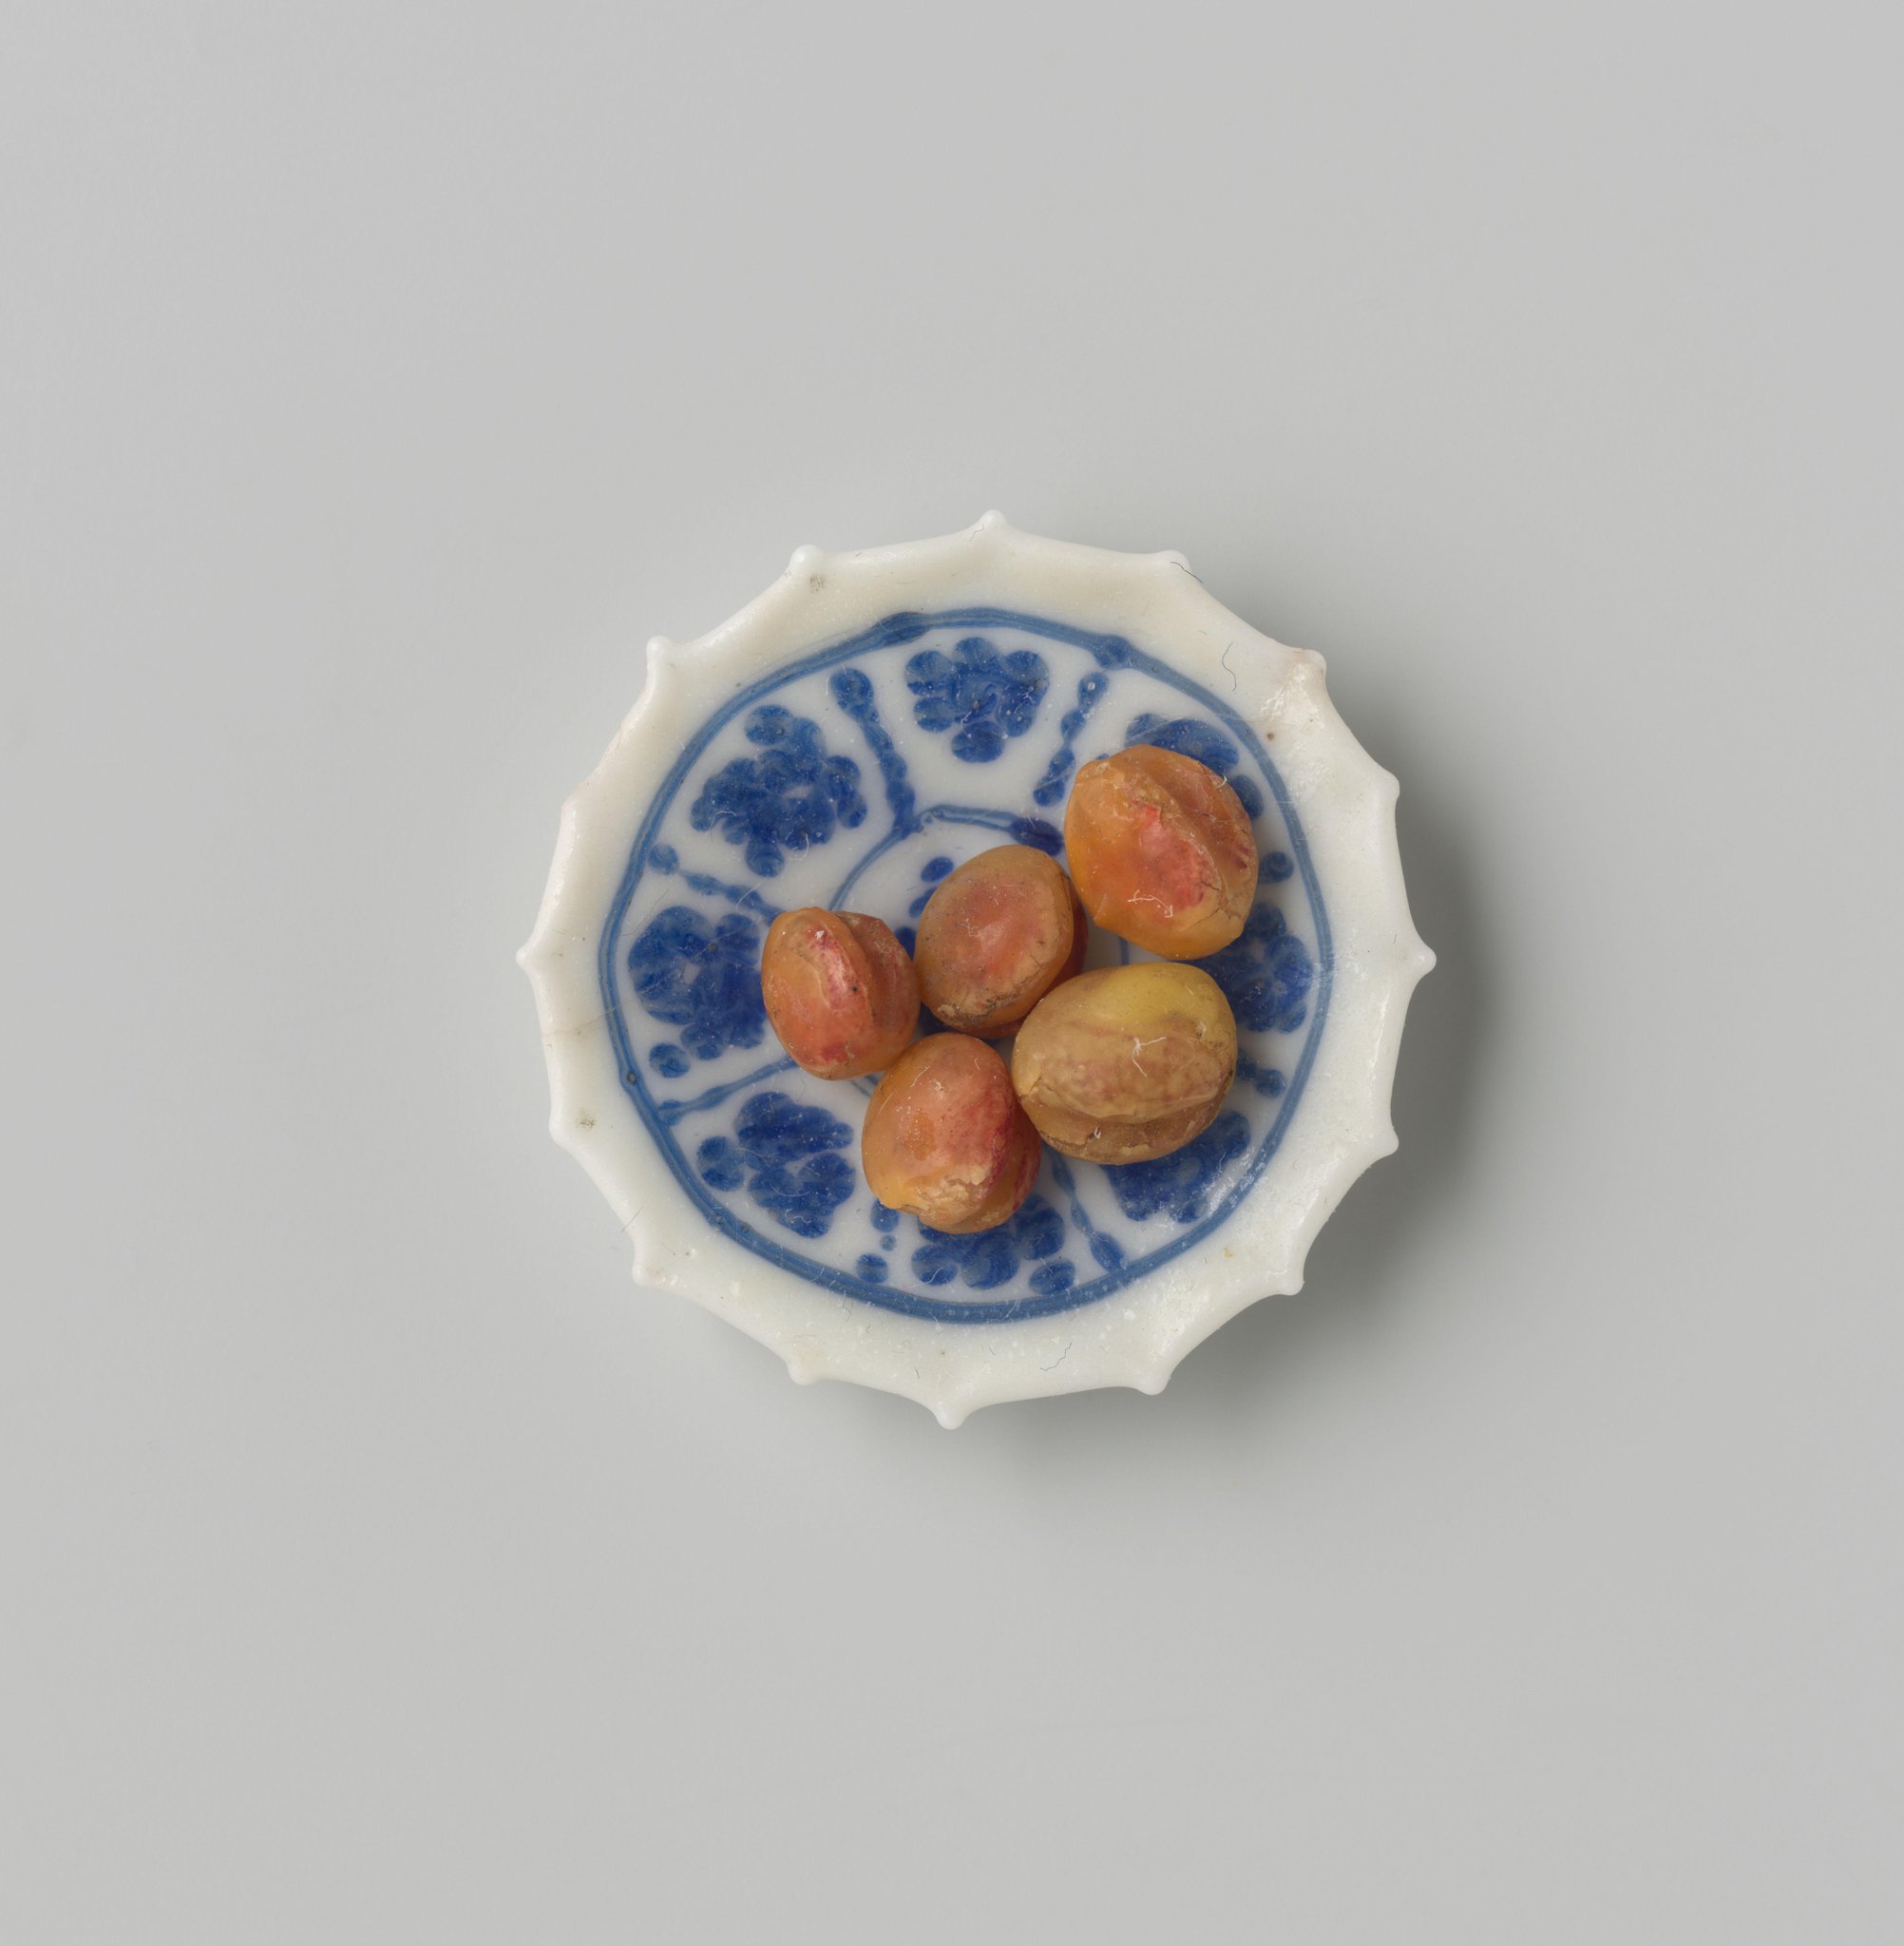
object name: miniature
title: Schotel van melkglas met blauwe emailverf beschildering, imitatie Chinees porselein; bloemmotieven in vakken in Kraakporselein stijl; dubbelwandig met in punten geknepen rand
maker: Anonymous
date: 1675-1710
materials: glass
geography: amsterdam